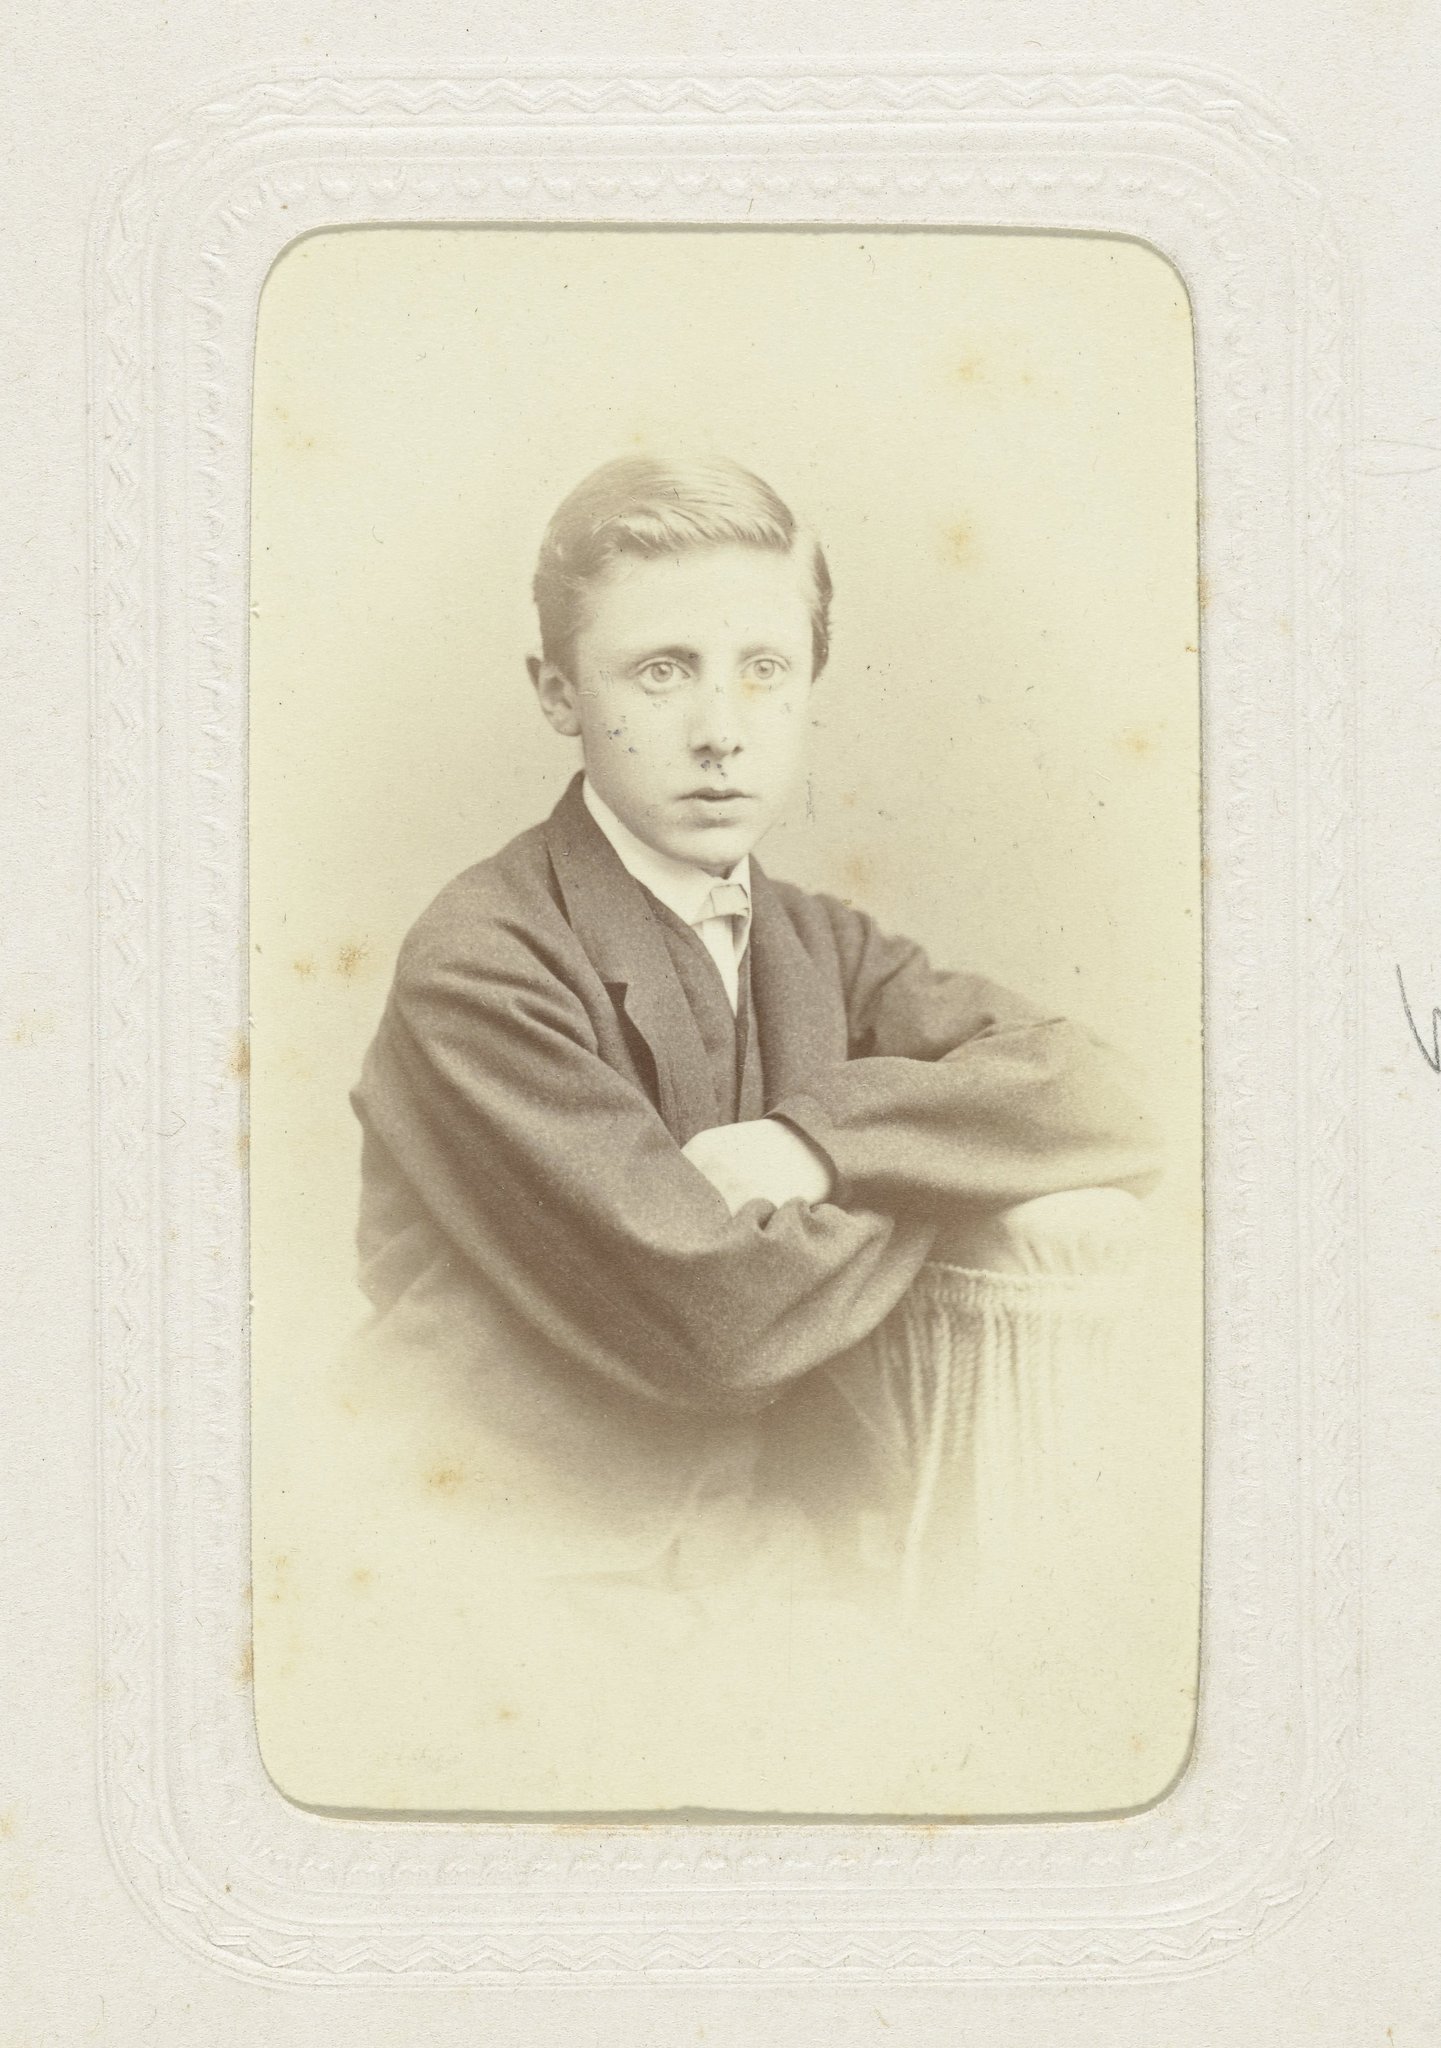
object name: carte de visite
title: Studioportret van een jongen met zijn armen over elkaar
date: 1863-1866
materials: cardboard, paper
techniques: albumen print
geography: amsterdam